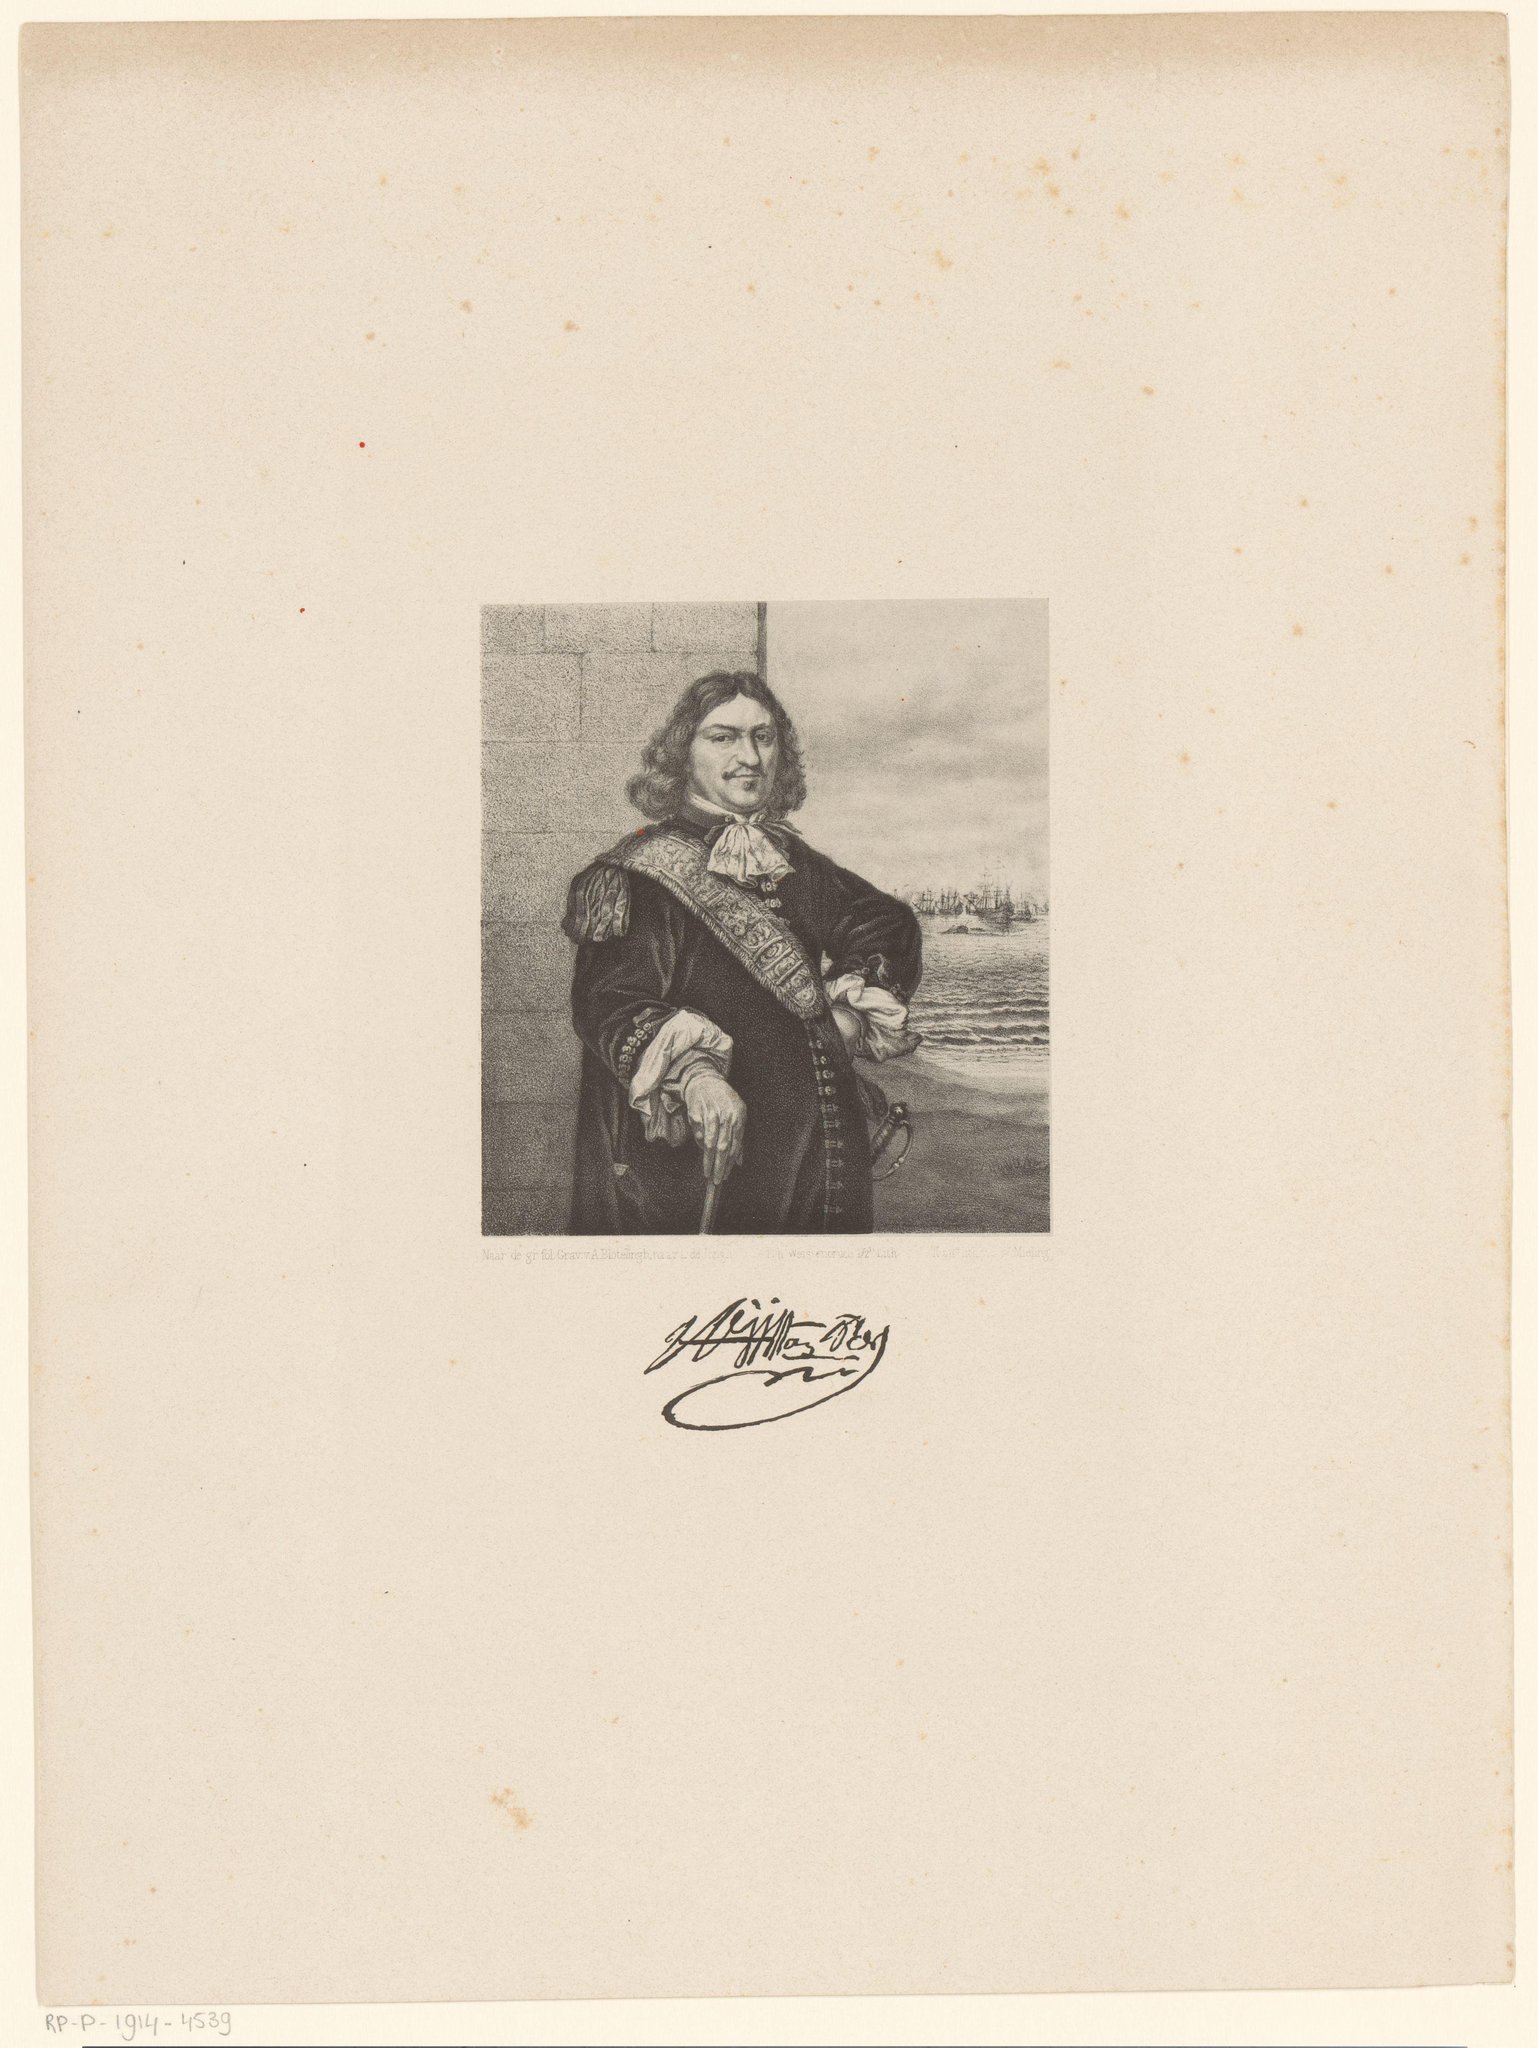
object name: print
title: Portret van Aert Jansz. van Nes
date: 1858-1862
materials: paper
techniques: lithograph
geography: the hague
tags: rotterdam, historical persons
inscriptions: collector's mark: Lugt 2228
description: Prent uit: Jonge, J.C. de. Geschiedenis van het Nederlandsche zeewezen. Haarlem: Jonge, J.K.J. de, 1858-62.